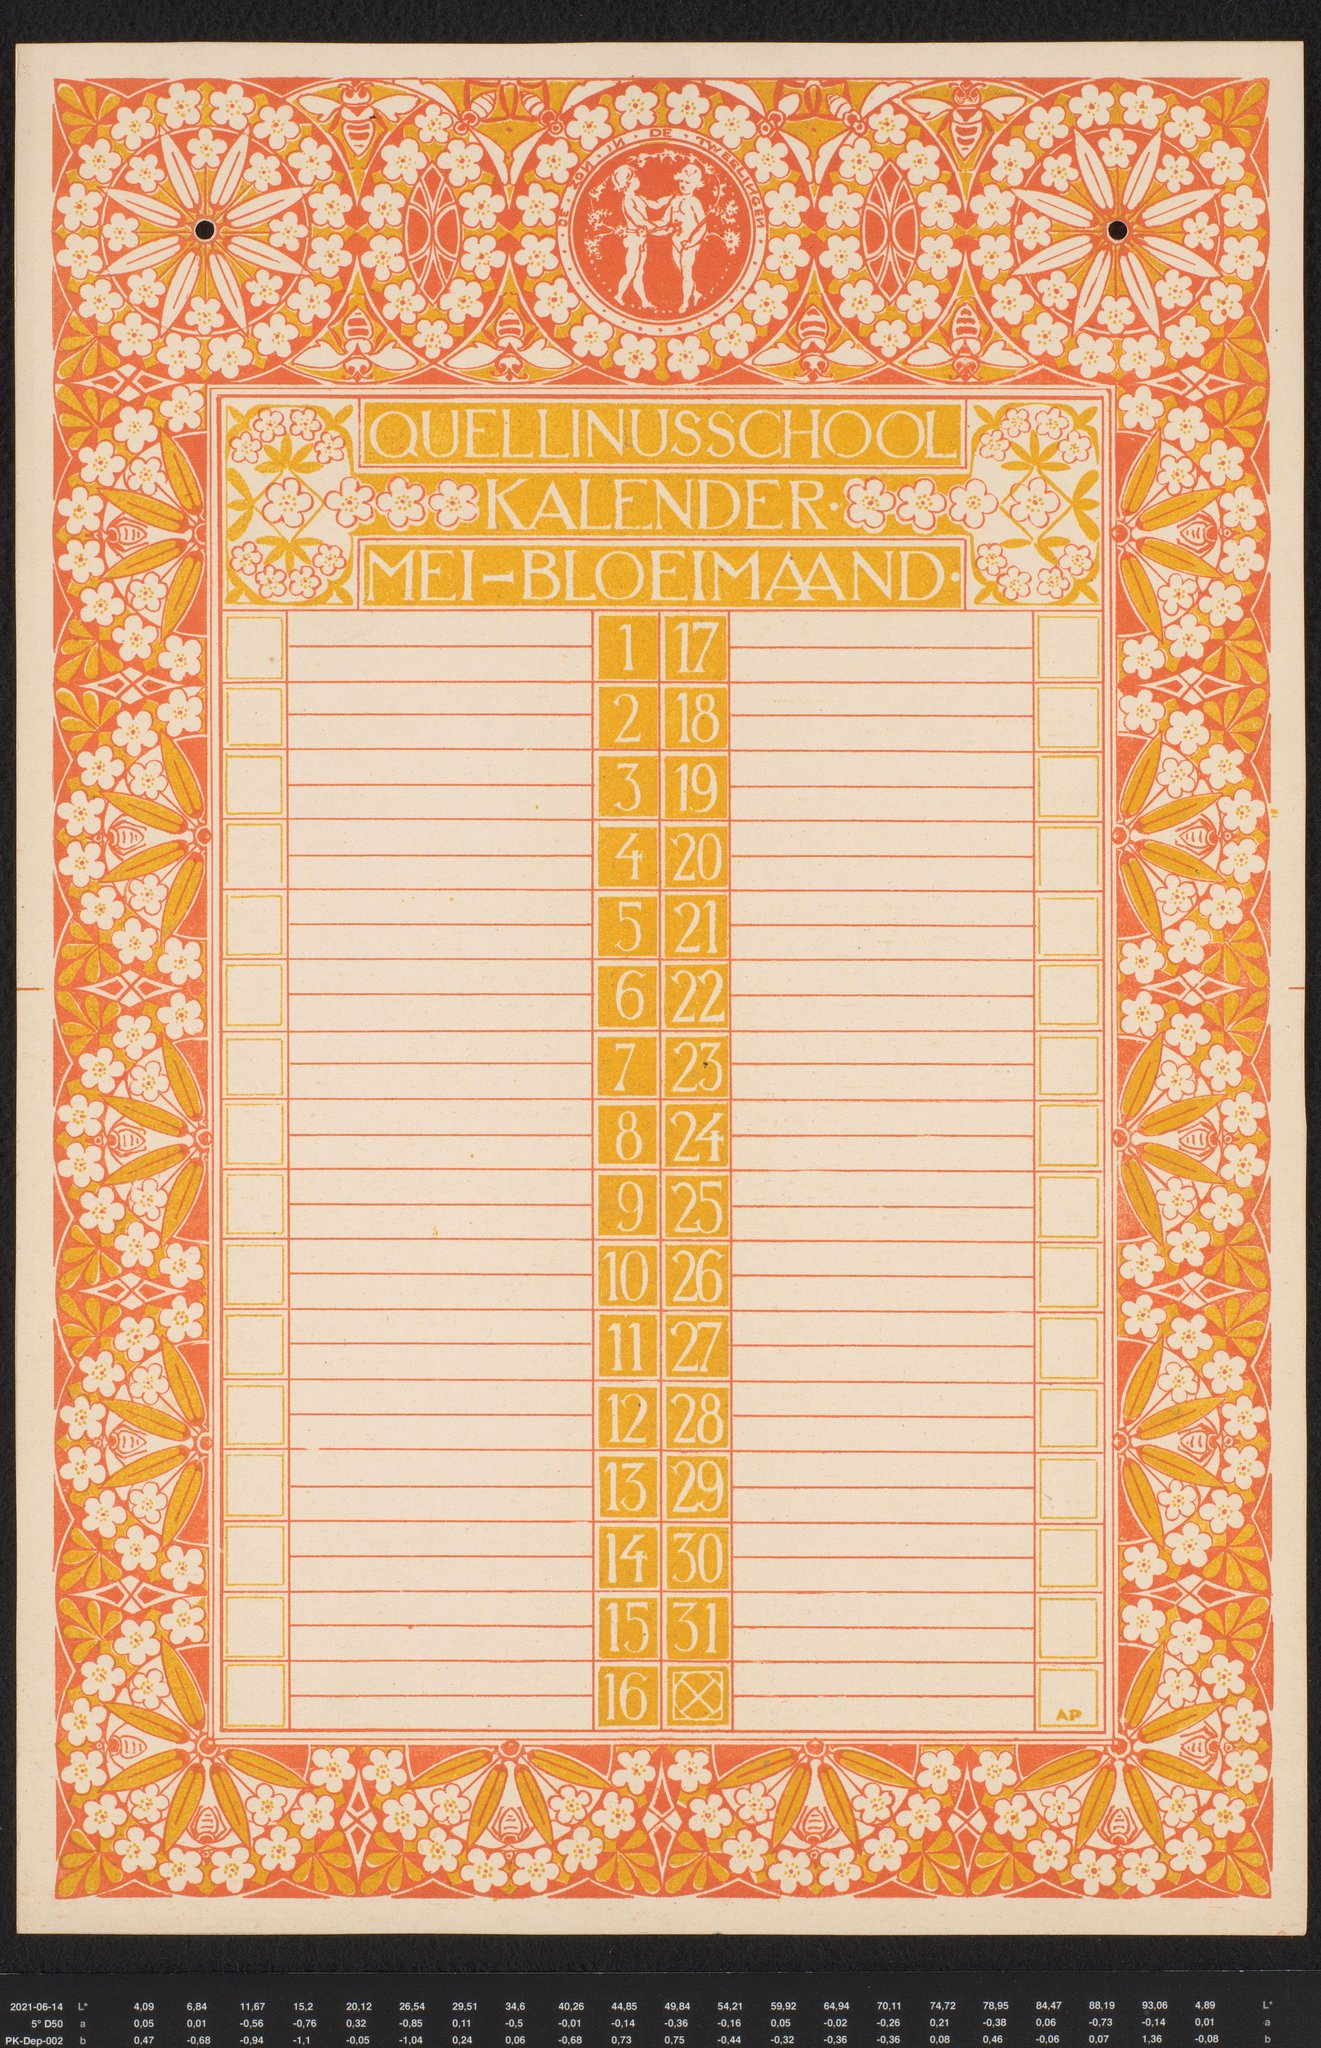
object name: print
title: Kalenderblad voor de bloeimaand, mei, van een kalender van Kunstnijverheidsschool Quellinus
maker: Anonymous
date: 1885-1925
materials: paper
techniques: lithograph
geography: amsterdam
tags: ornaments ~ art, calendar, almanac, insects: bee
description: Met een randdecoratie met bloemen, bijen en bladeren, en bovenin een vignet met twee naakte figuren met daaromheen de tekst: 'De zon in de tweelingen'.